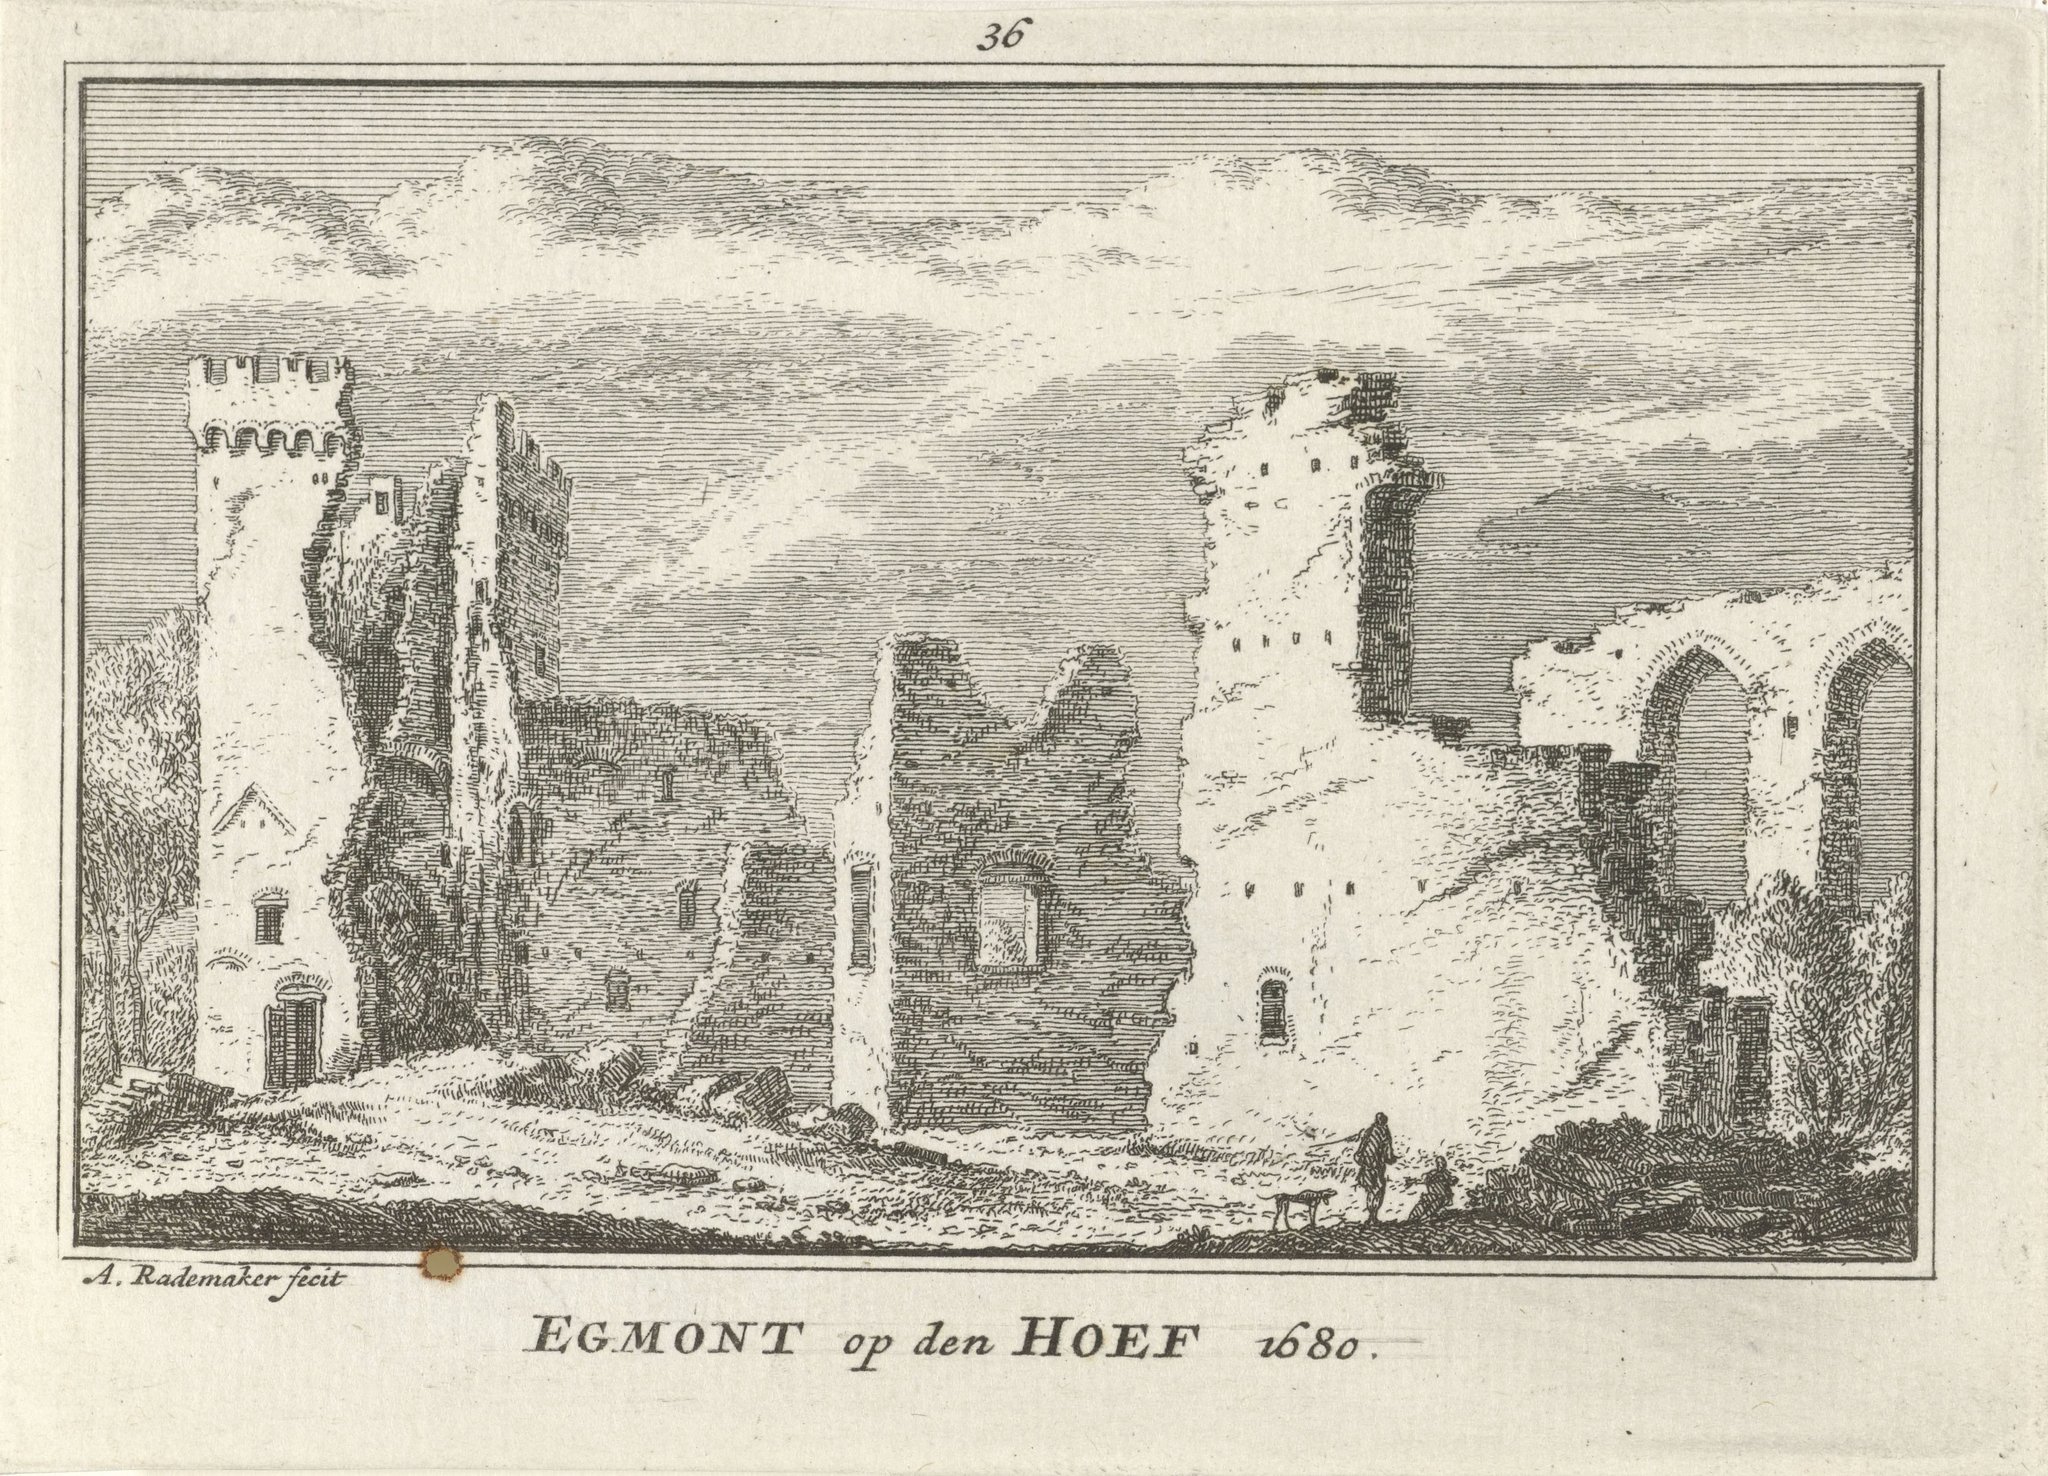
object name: print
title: Egmont op den Hoef 1680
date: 1727-1733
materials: paper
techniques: etching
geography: amsterdam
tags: castle, ruin of a dwelling, house, castle, etc.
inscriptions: collector's mark: Lugt 2228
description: Illustratie uit: Abraham Rademaker, Matthaeus Brouërius van Niedek, Isaac Le Long, Kabinet van Nederlandsche en Kleefsche outheden en (...) voorname stads- en landgebouwen, Willem Barents en Antoni Schoonenburg: Amsterdam, 1727-1733, ill. nr. 36.